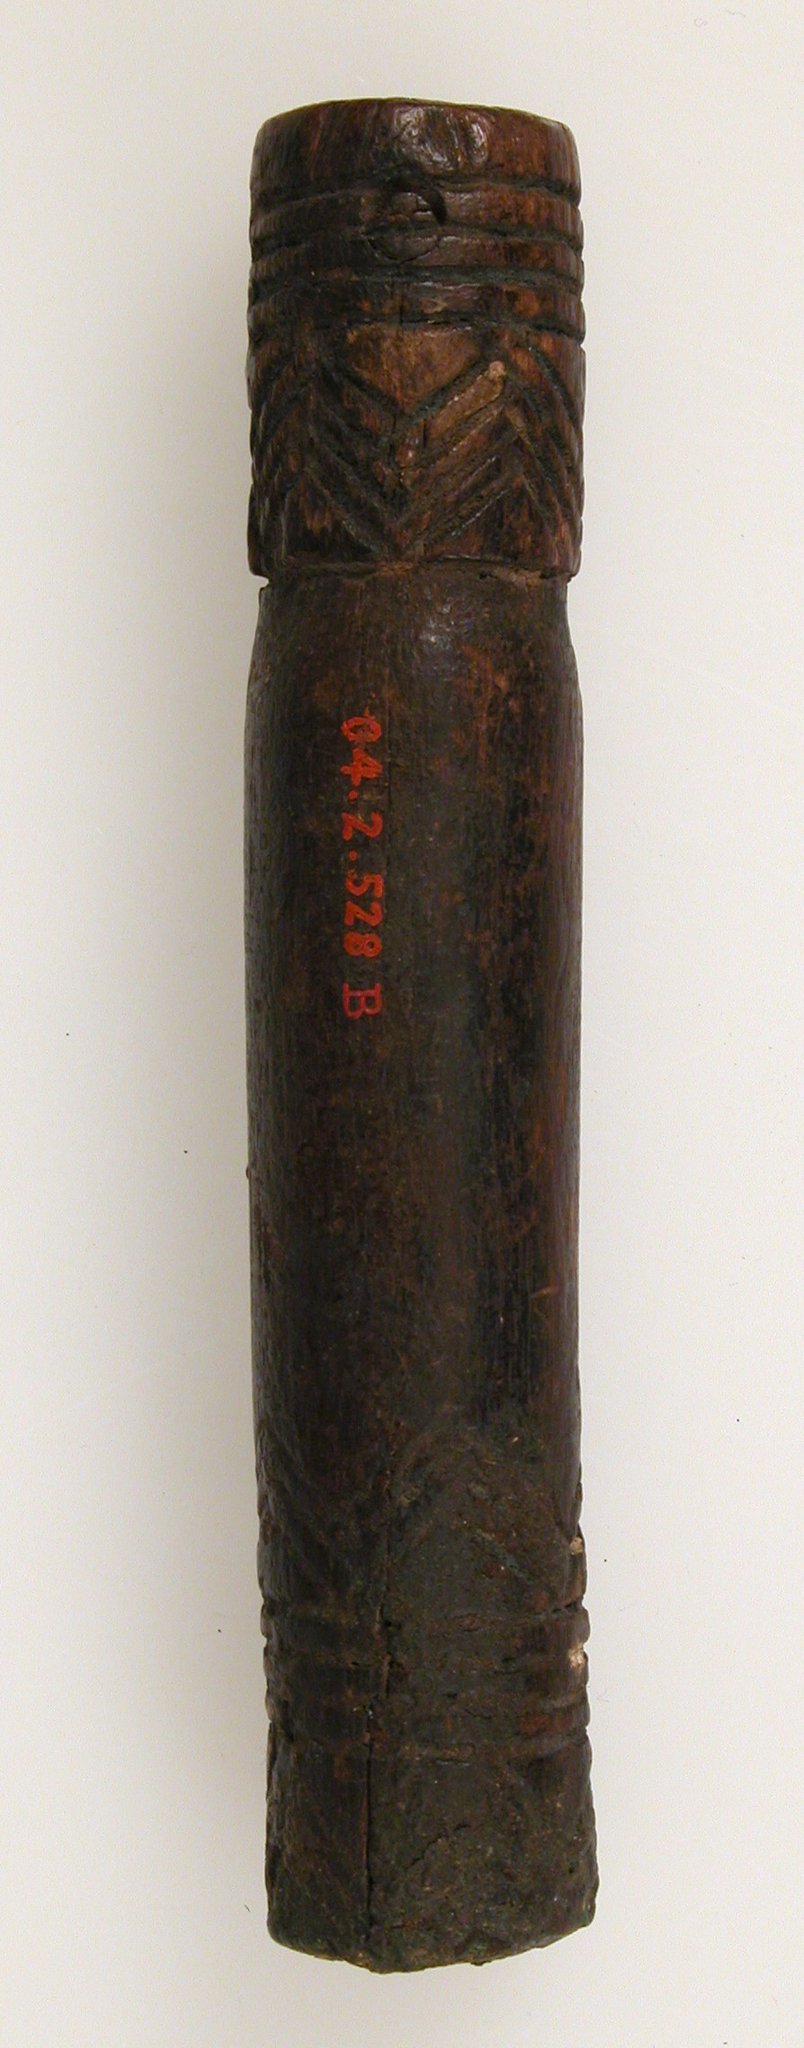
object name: tube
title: Kohl Tube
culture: byzantine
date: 501-700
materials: wood